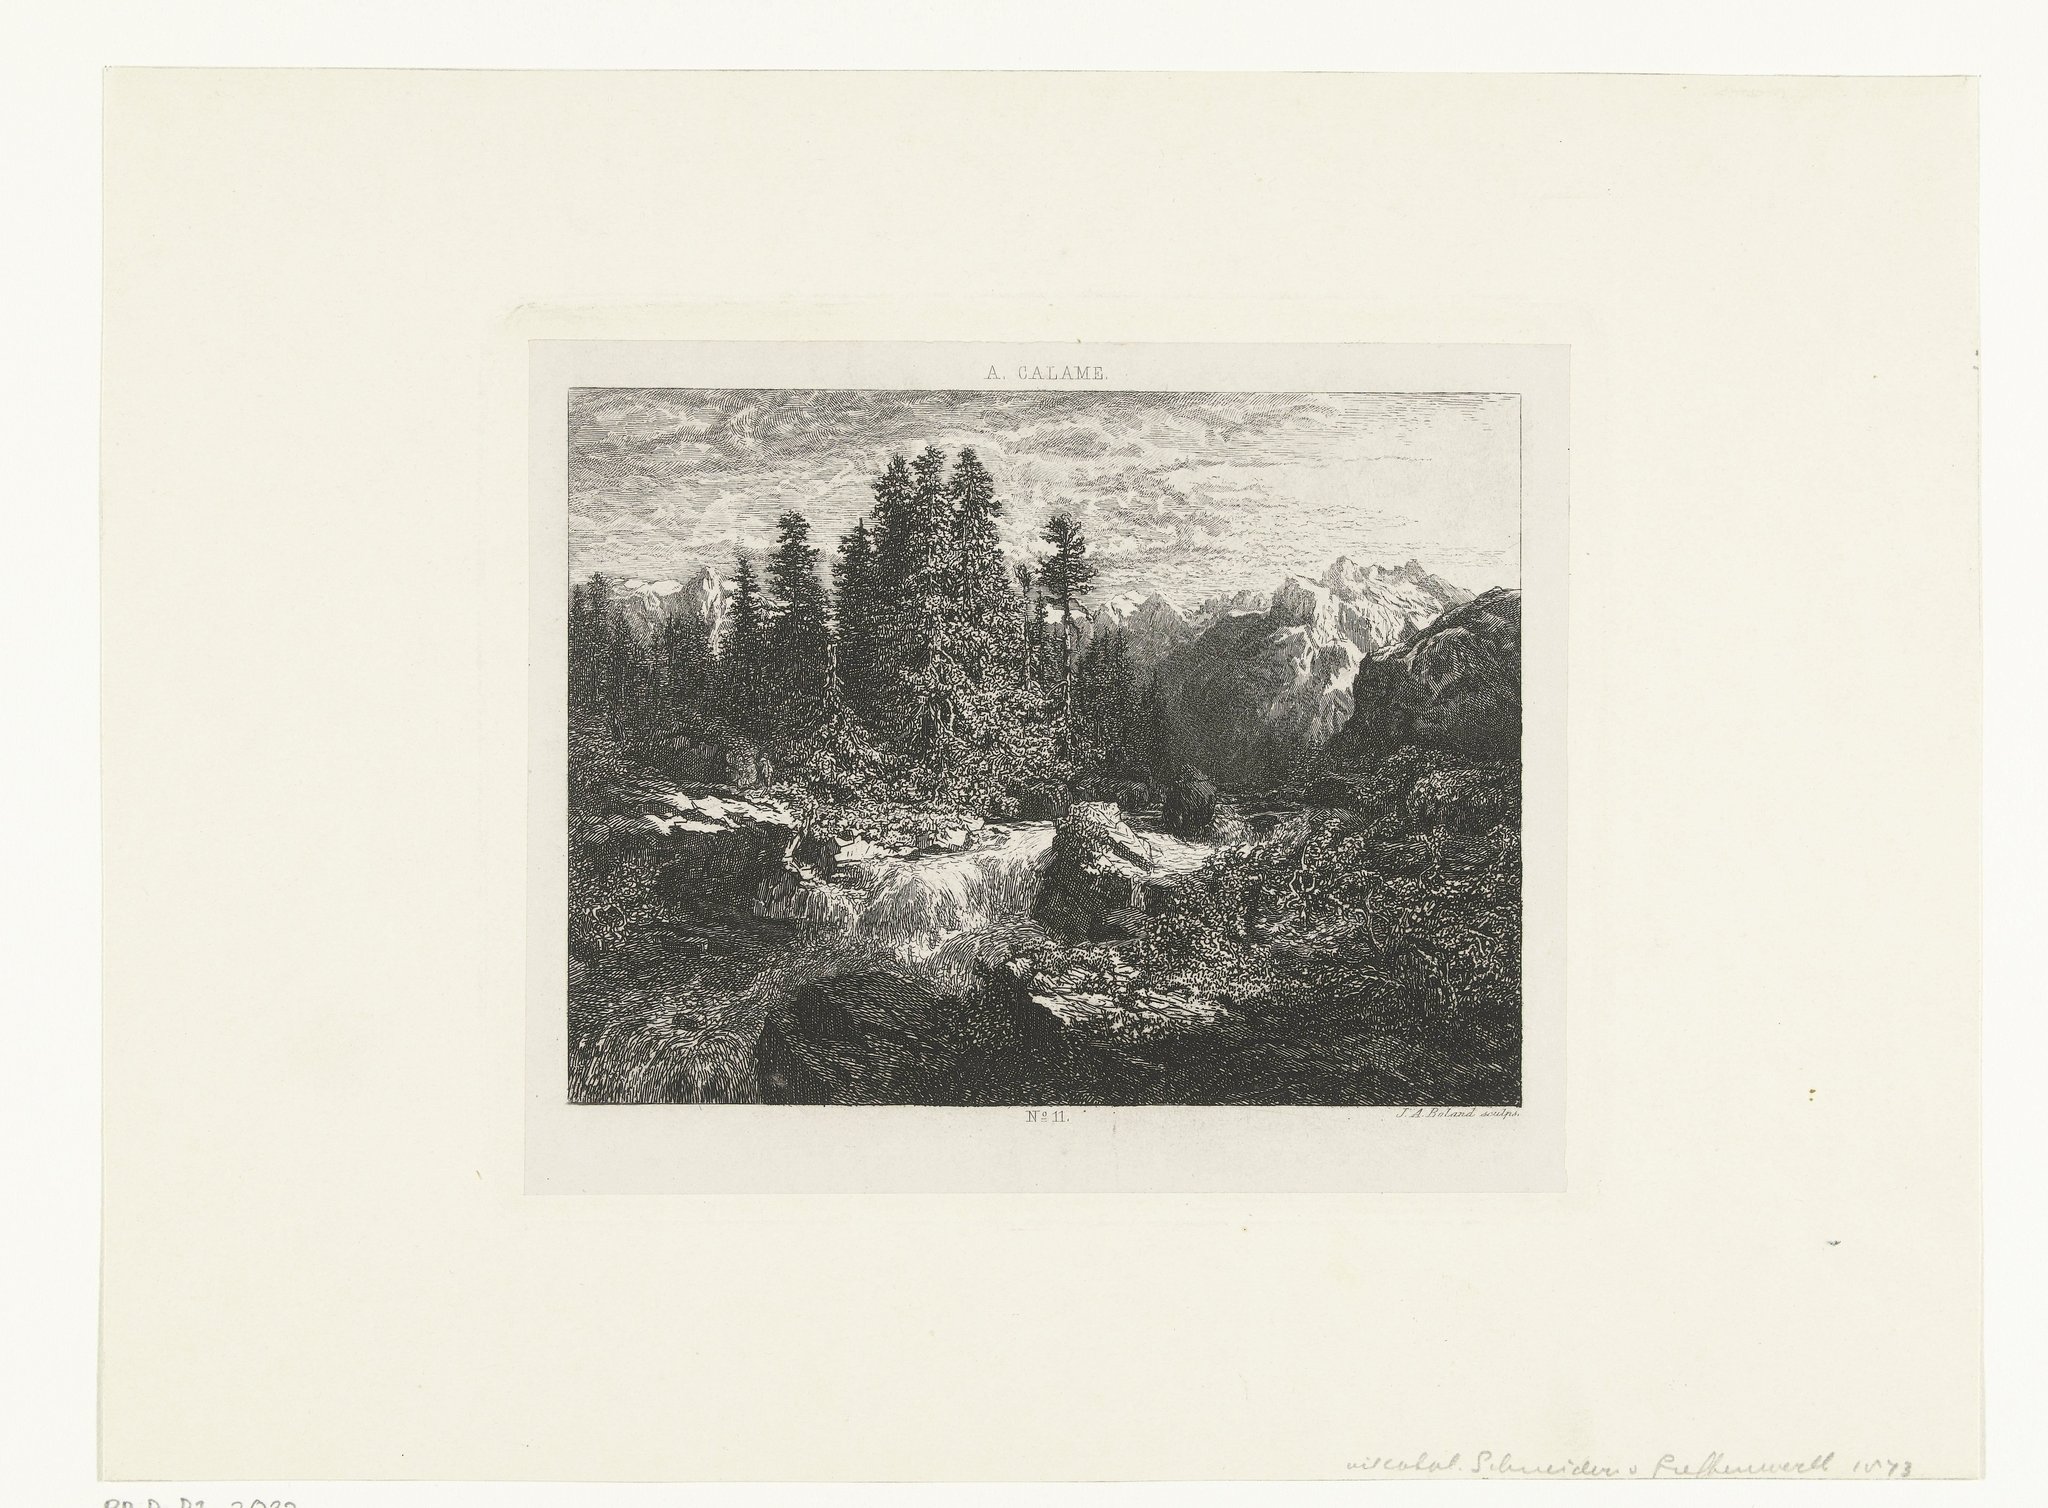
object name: print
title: Berglandschap met beek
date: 1860-1900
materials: paper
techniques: etching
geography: amsterdam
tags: brook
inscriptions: collector's mark: Lugt 2165